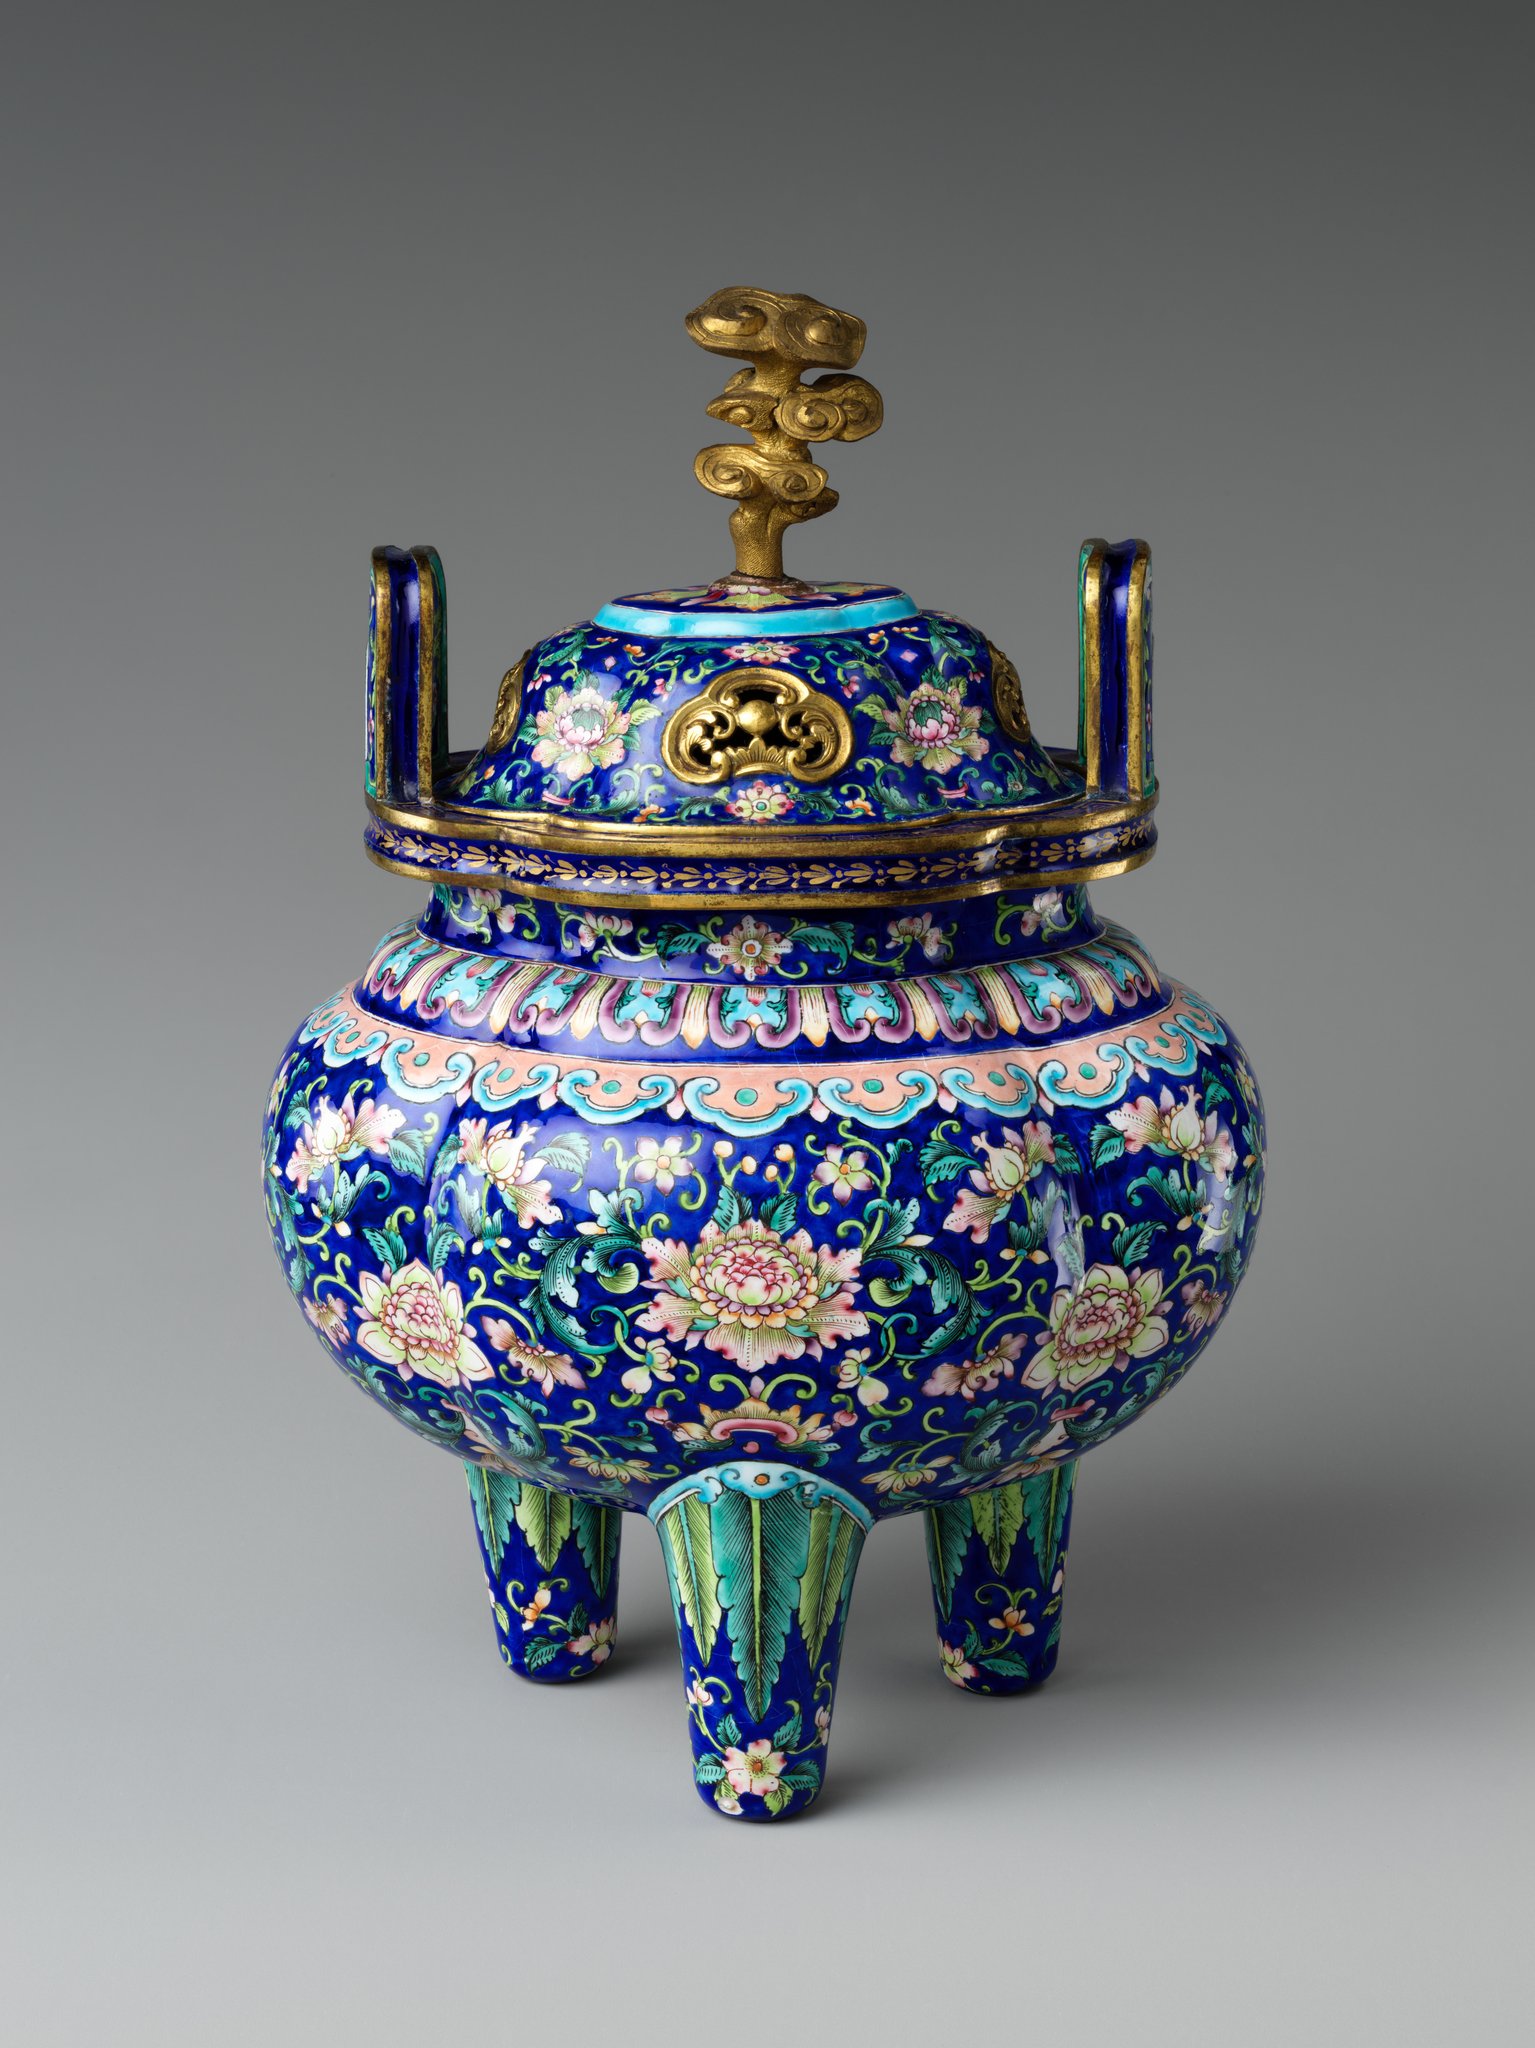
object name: incense burner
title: Incense burner (from set)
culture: chinese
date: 1751-1800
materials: copper alloy, enamel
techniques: painting